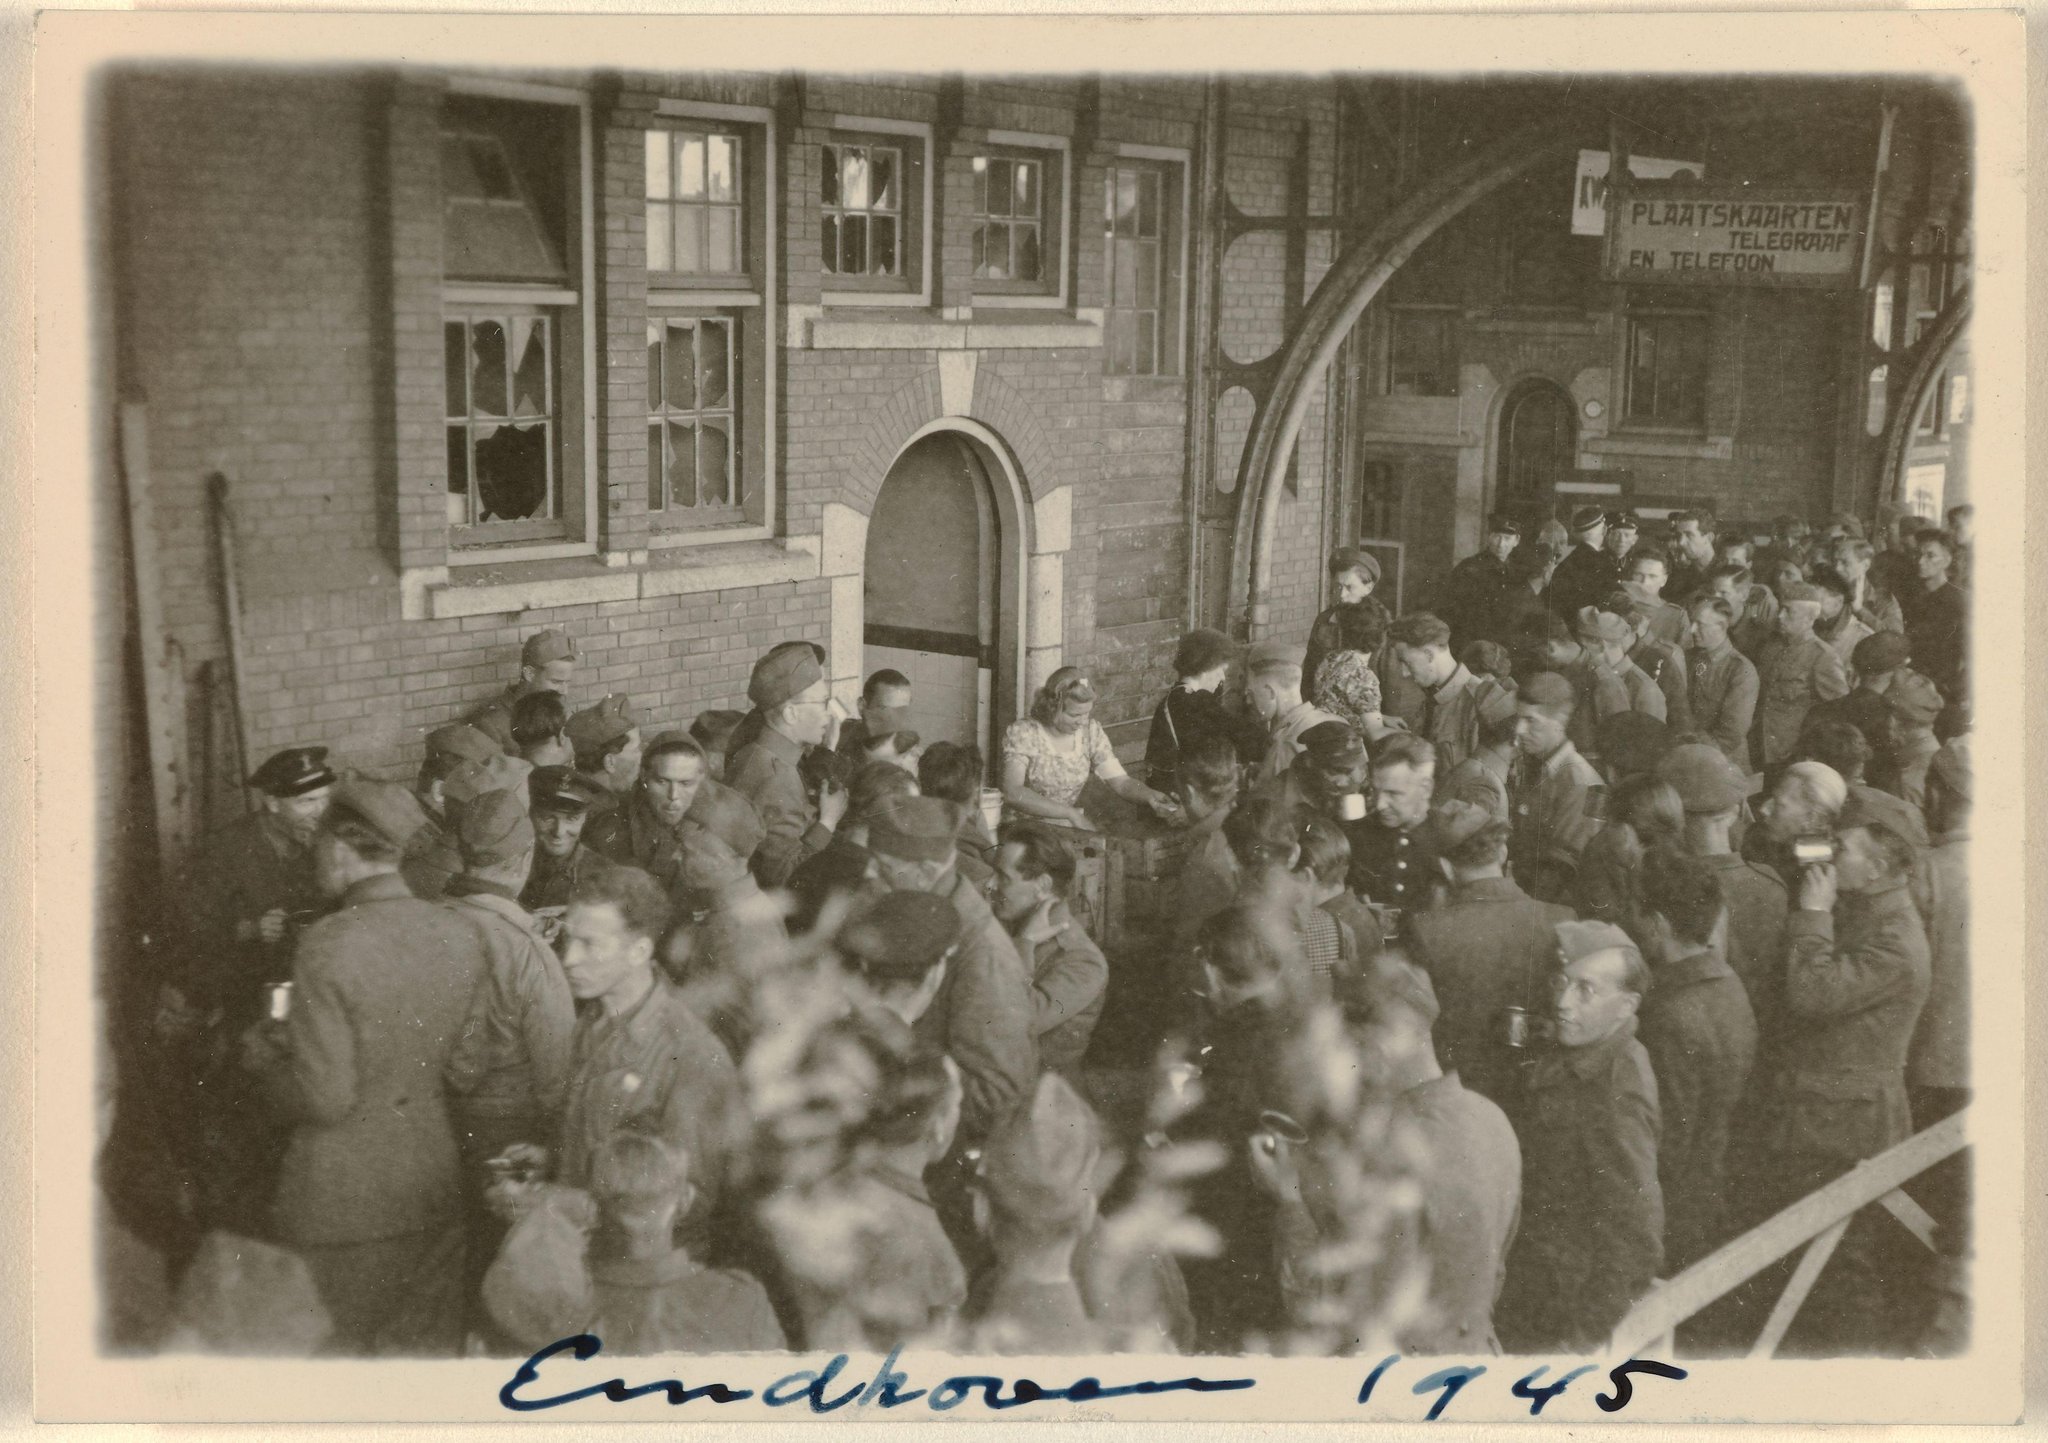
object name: photograph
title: Aankomst in Weert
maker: dick w.b. van maarseveen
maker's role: fotograaf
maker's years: 1905-1990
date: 1945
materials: photographic support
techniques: gelatin silver print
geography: muhlberg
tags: the hague, dick w.b. van maarseveen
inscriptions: inscription: ‘Eindhoven 1945’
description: Aankomst van de trein met bevrijde Nederlandse krijgsgevangenen op het station van Weert (of Eindhoven), na een lange terugreis uit Duitsland, 1945. Onderdeel van een groep foto's gemaakt door Dick van Maarseveen in het Duitse krijgsgevangenenkamp Stalag IV B in Mühlberg in de periode 1943-1945.